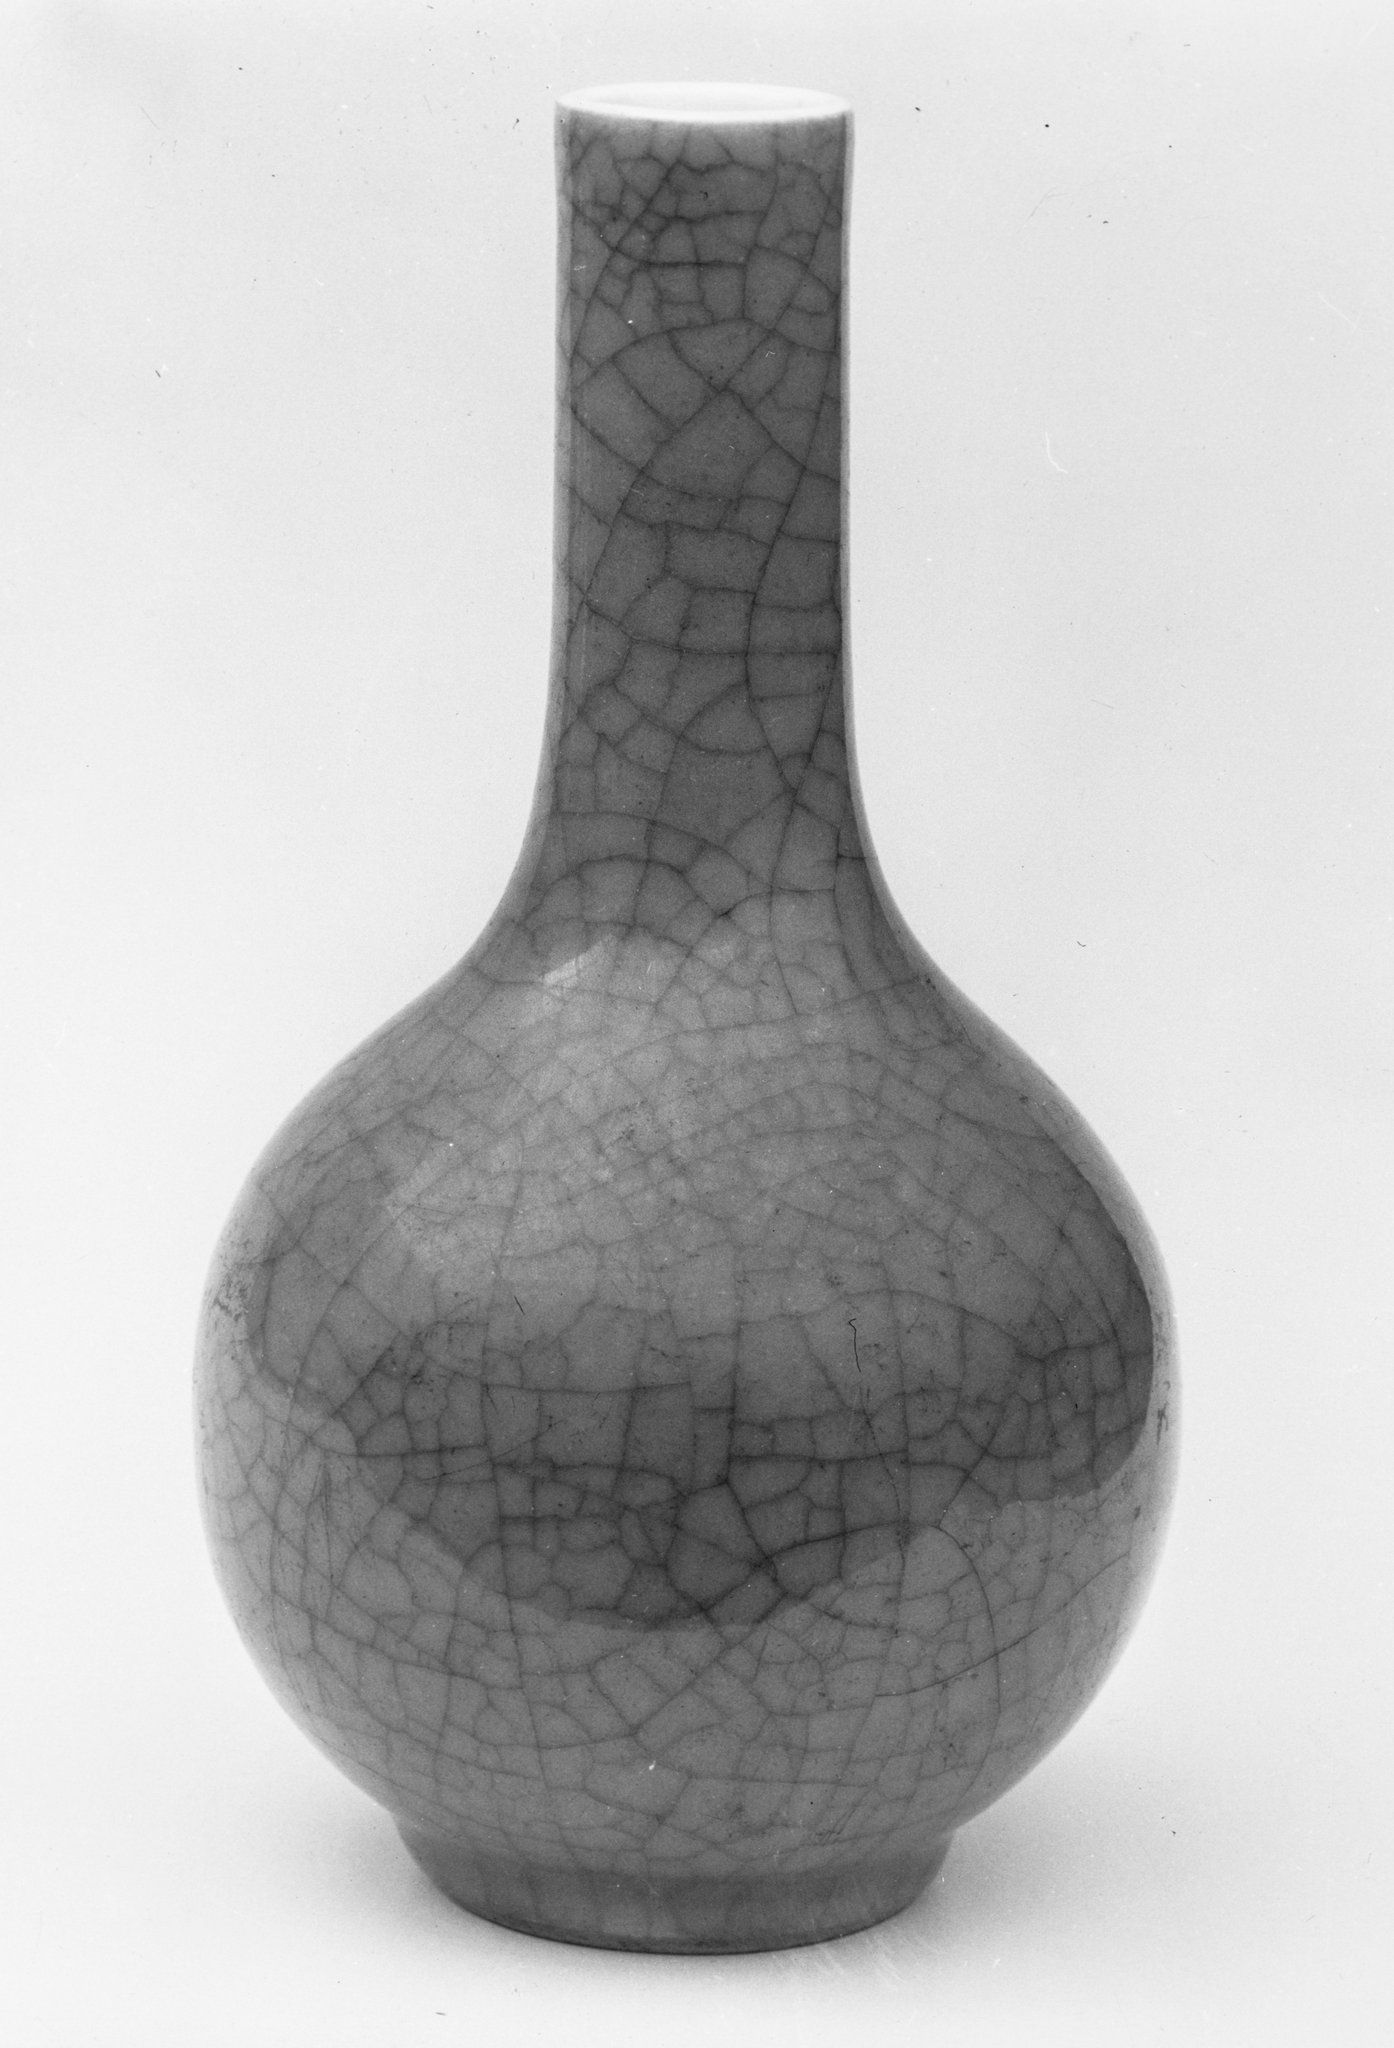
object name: bottle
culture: chinese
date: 1662-1722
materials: porcelain